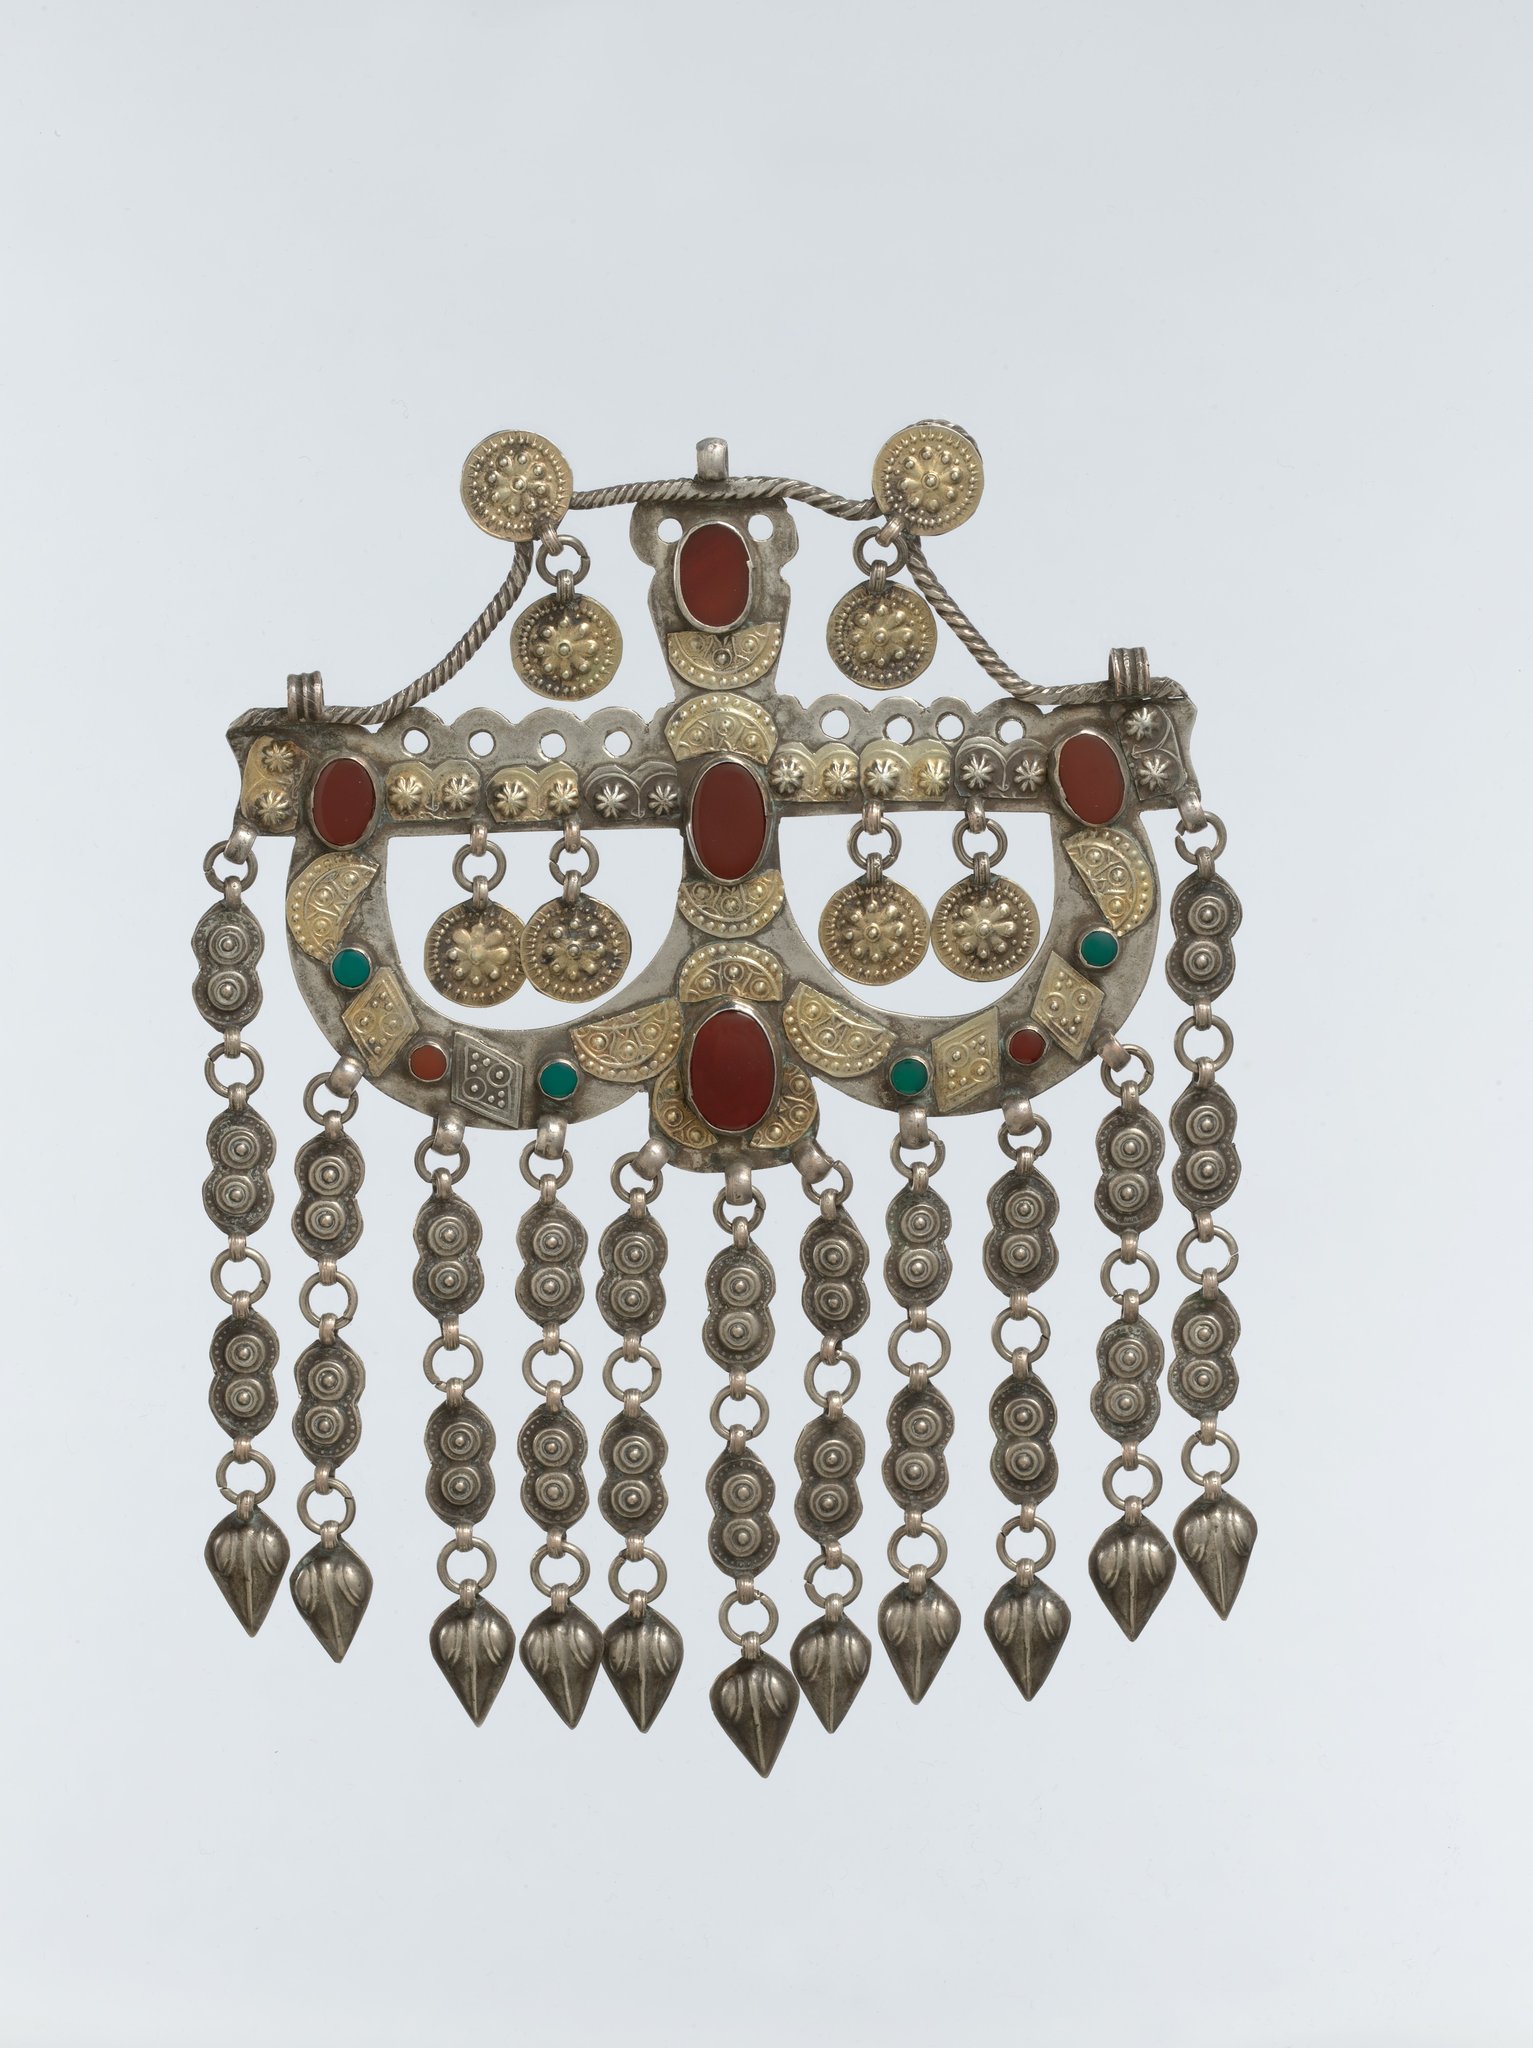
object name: ornament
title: Pectoral Ornament (?)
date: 1801-1900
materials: carnelian, glass, silver, stone, metal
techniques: cutting, embossing, gilding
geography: central asia